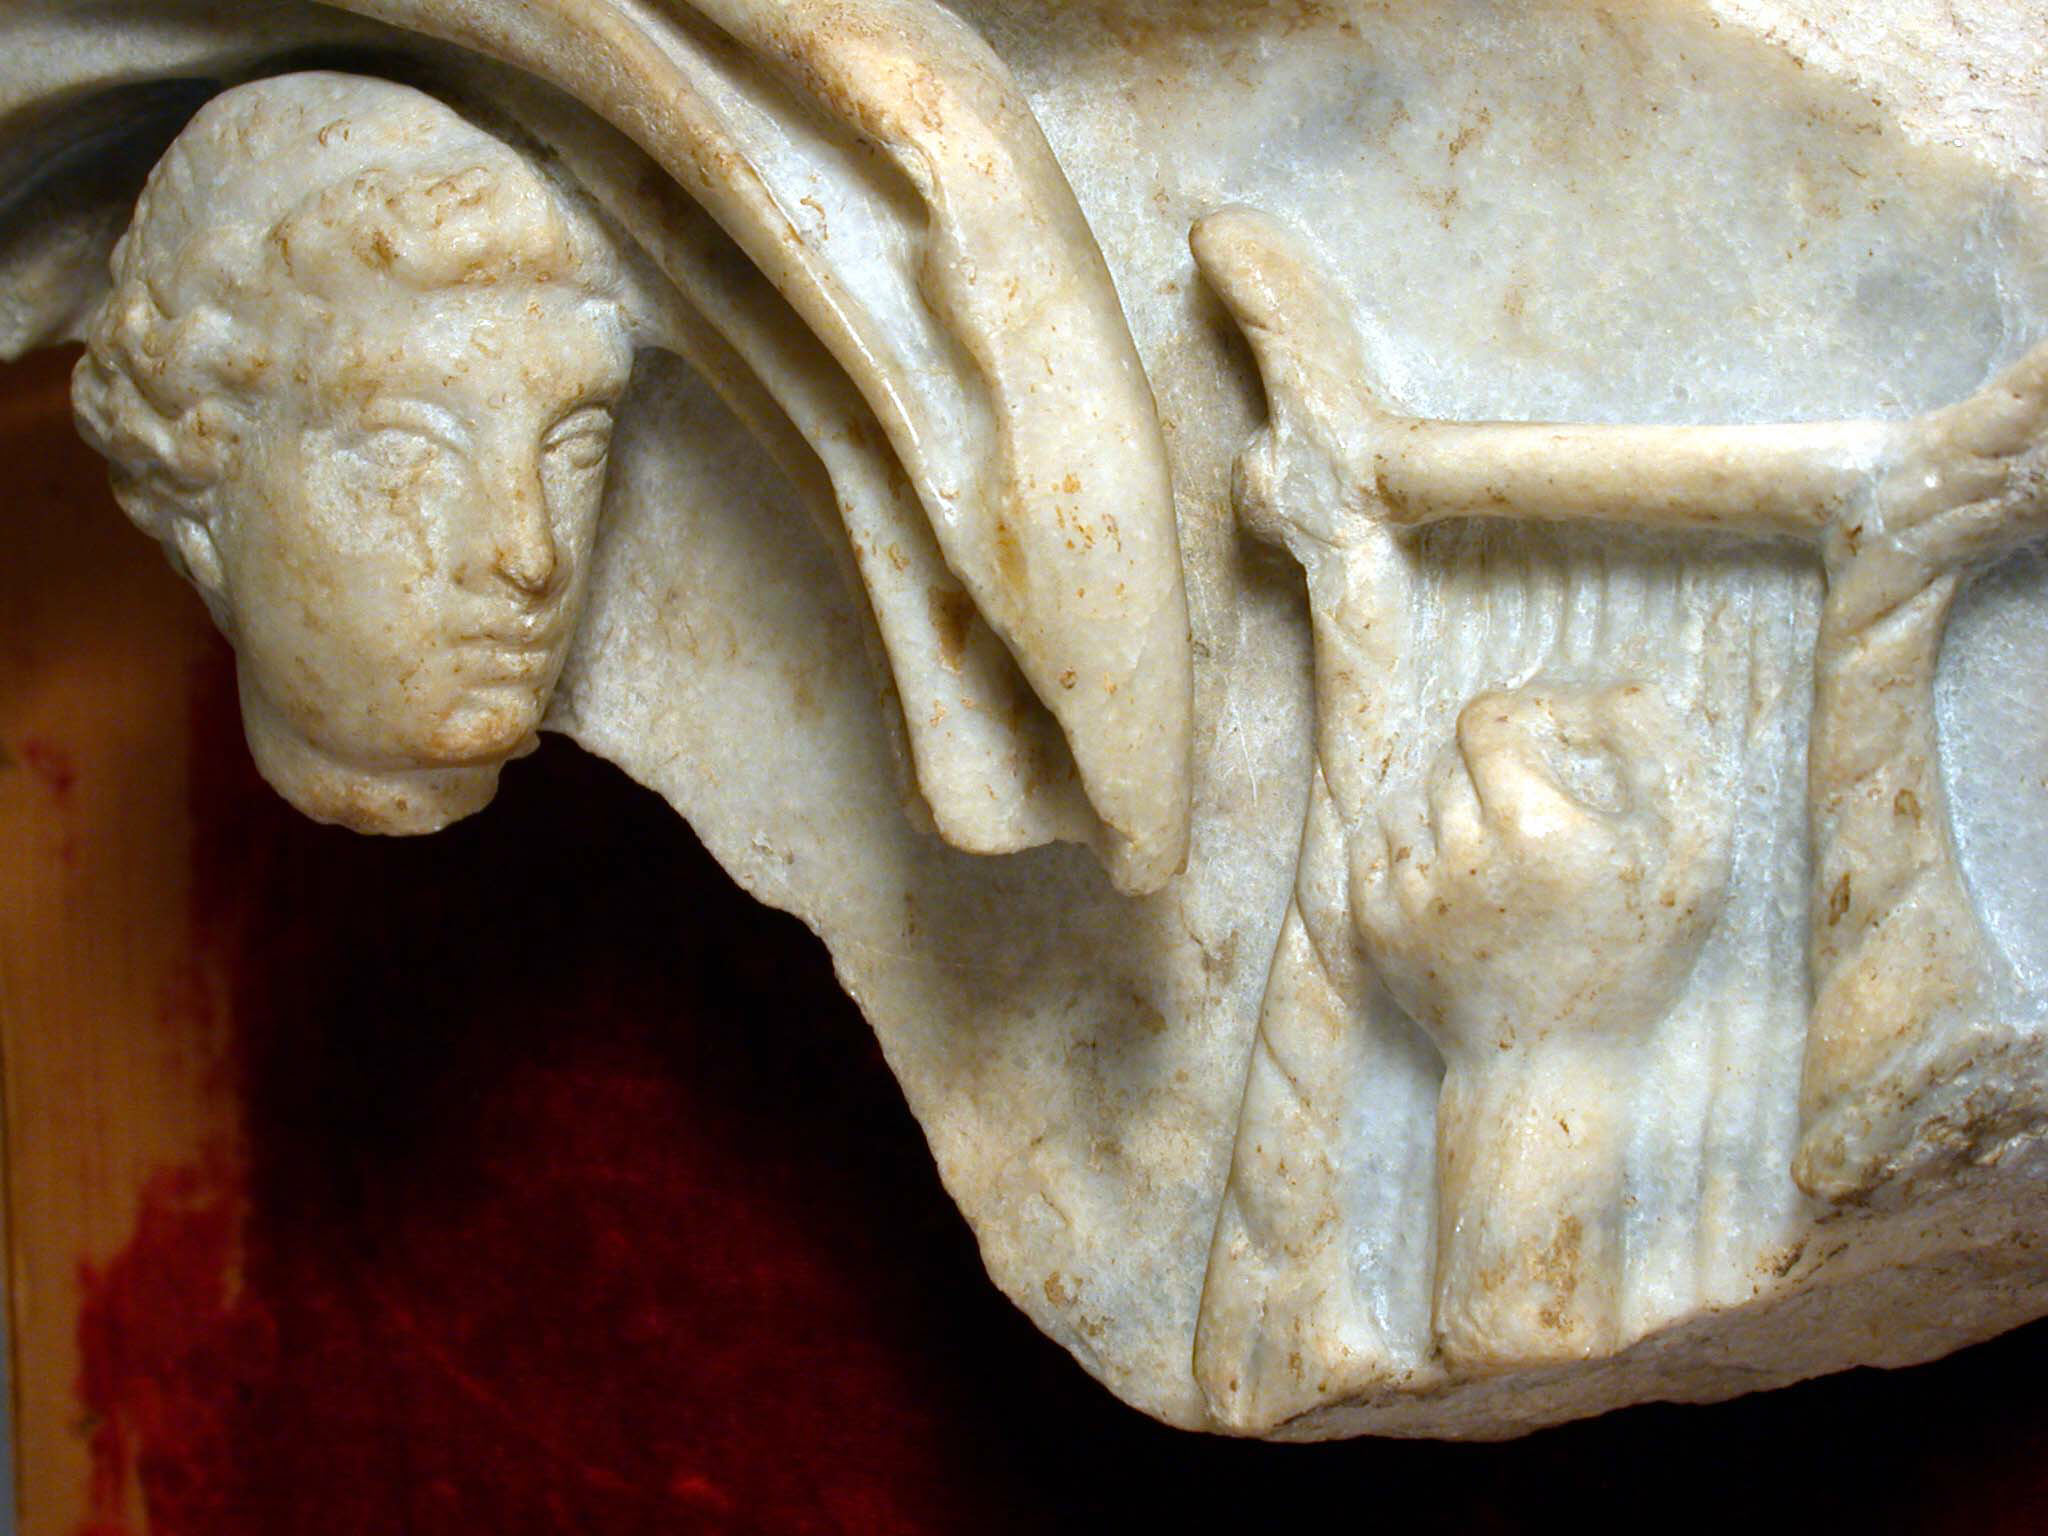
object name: sarcophagus fragment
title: Marble sarcophagus fragment of "The Judgement of Paris"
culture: roman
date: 201-300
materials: marble